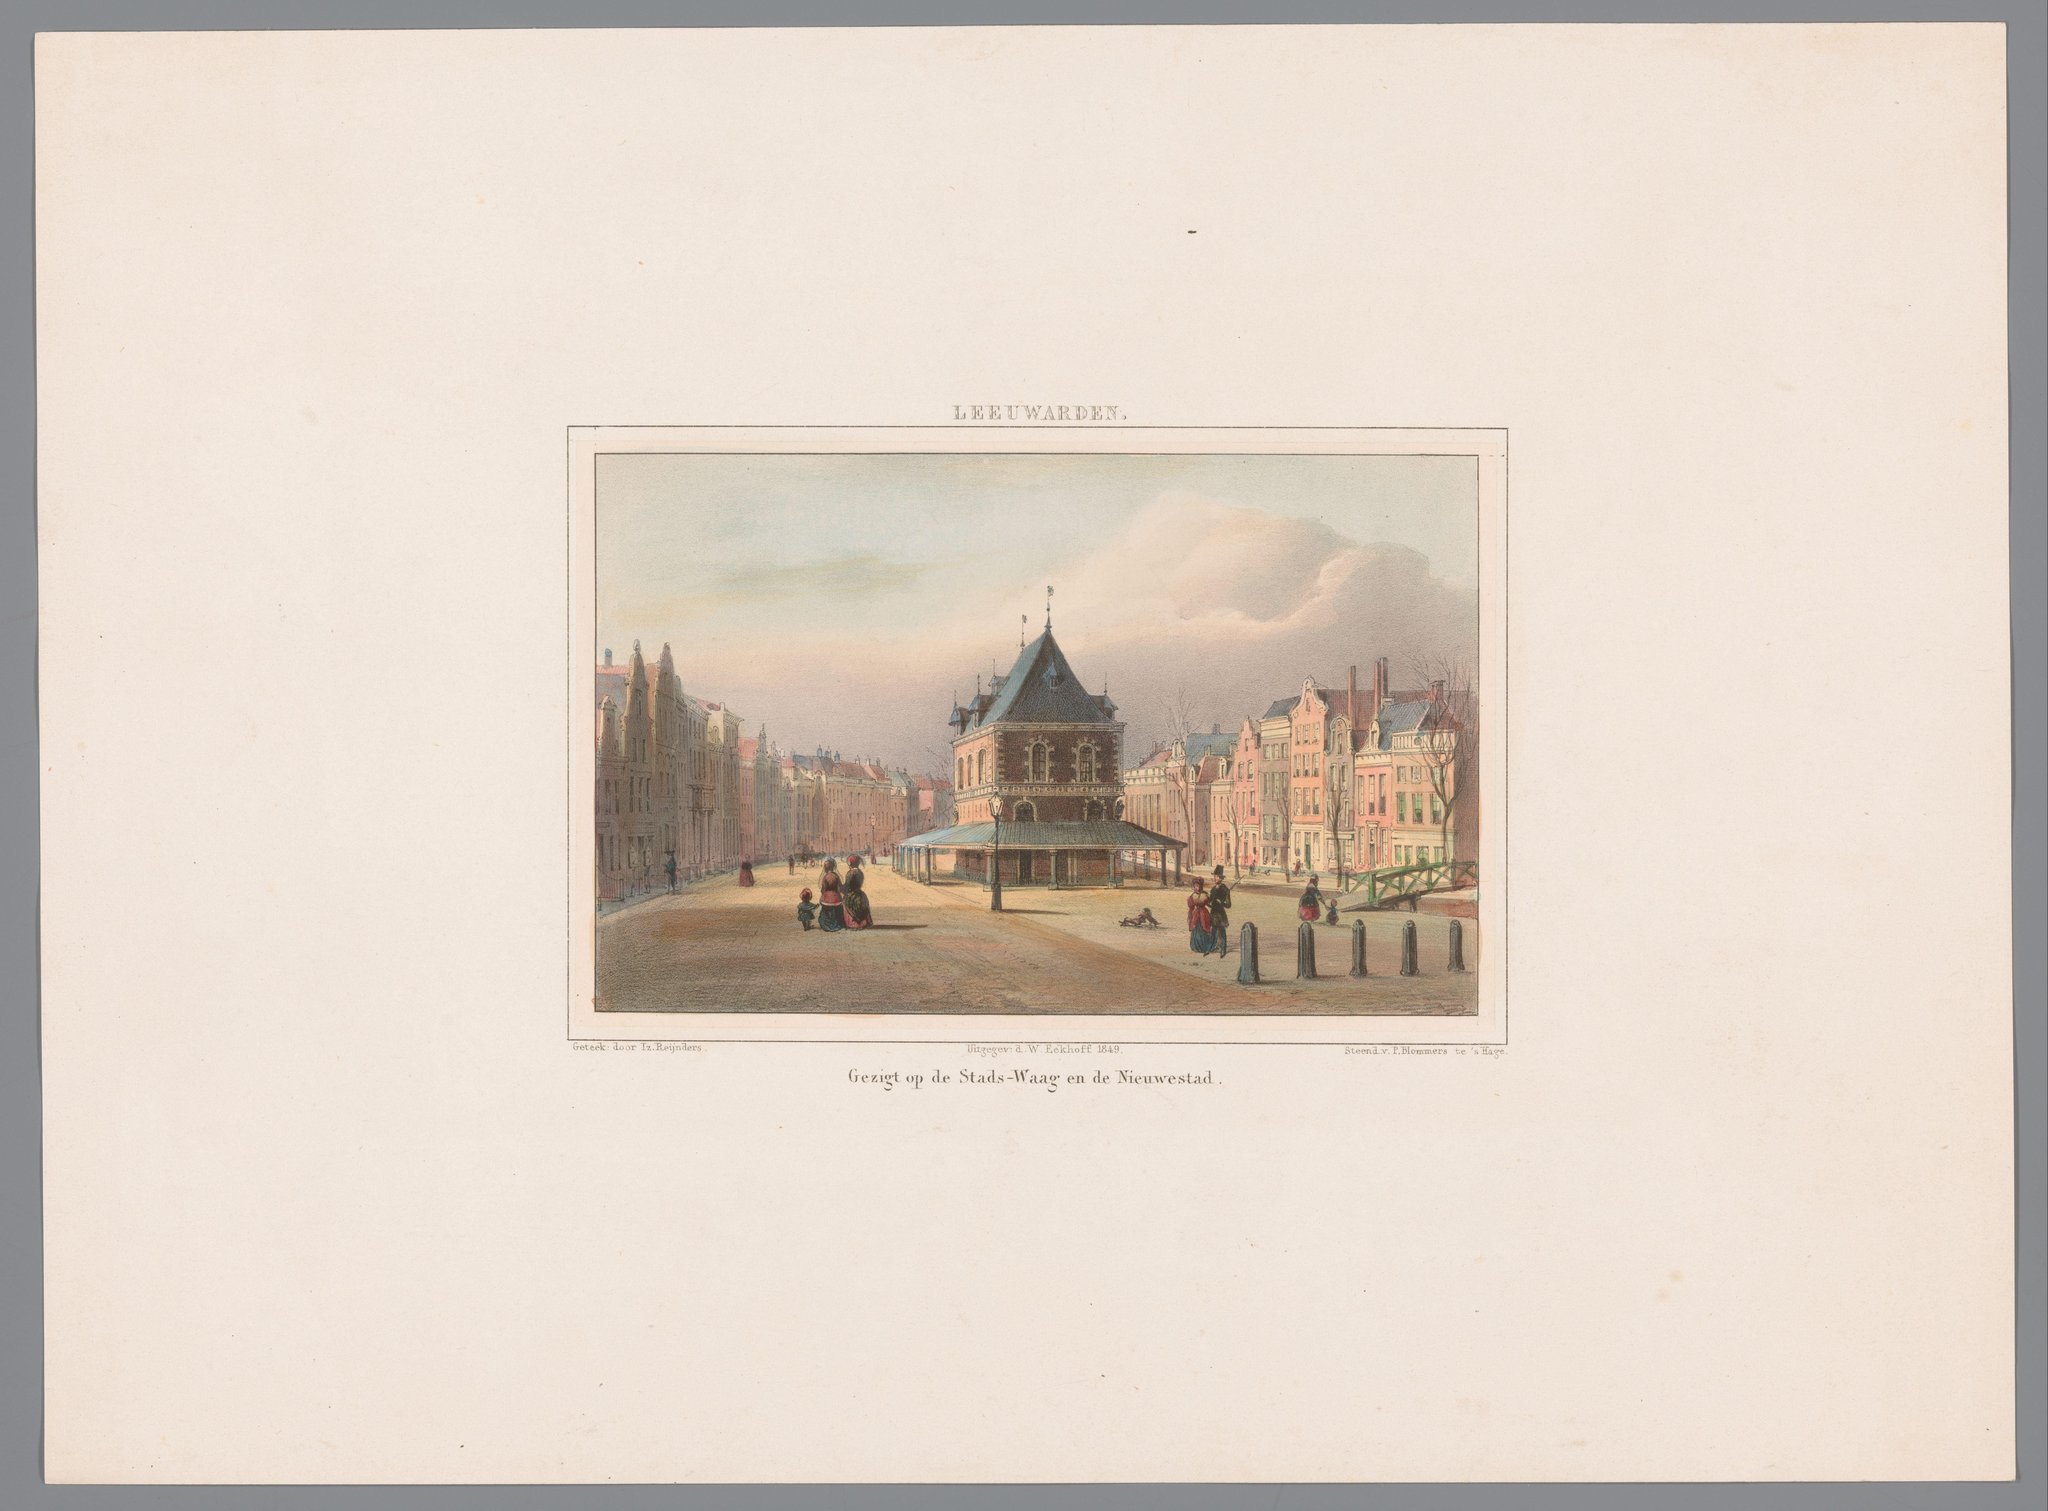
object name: print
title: Gezigt op de Stads-Waag en de Nieuwestad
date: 1849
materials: paper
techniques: hand coloring, lithograph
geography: the hague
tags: city-view in general; 'veduta'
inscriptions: collector's mark: Lugt 2228